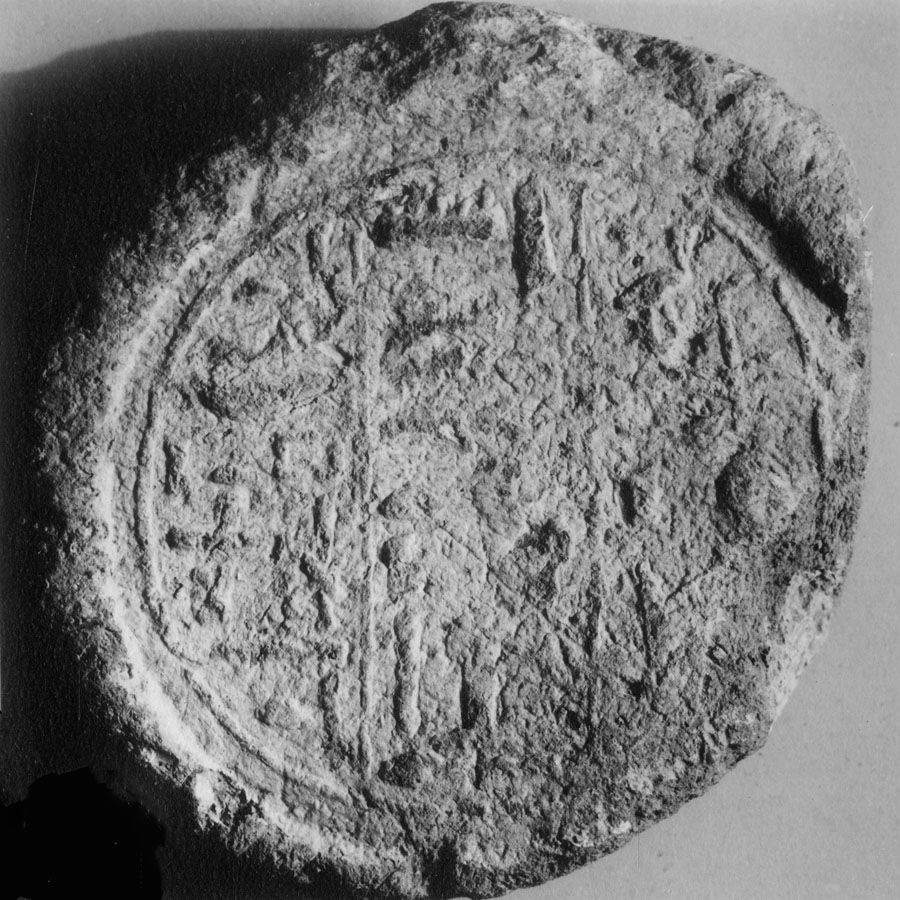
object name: cone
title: Funerary Cone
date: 1550-1295 BCE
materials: pottery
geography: egypt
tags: hieroglyphs